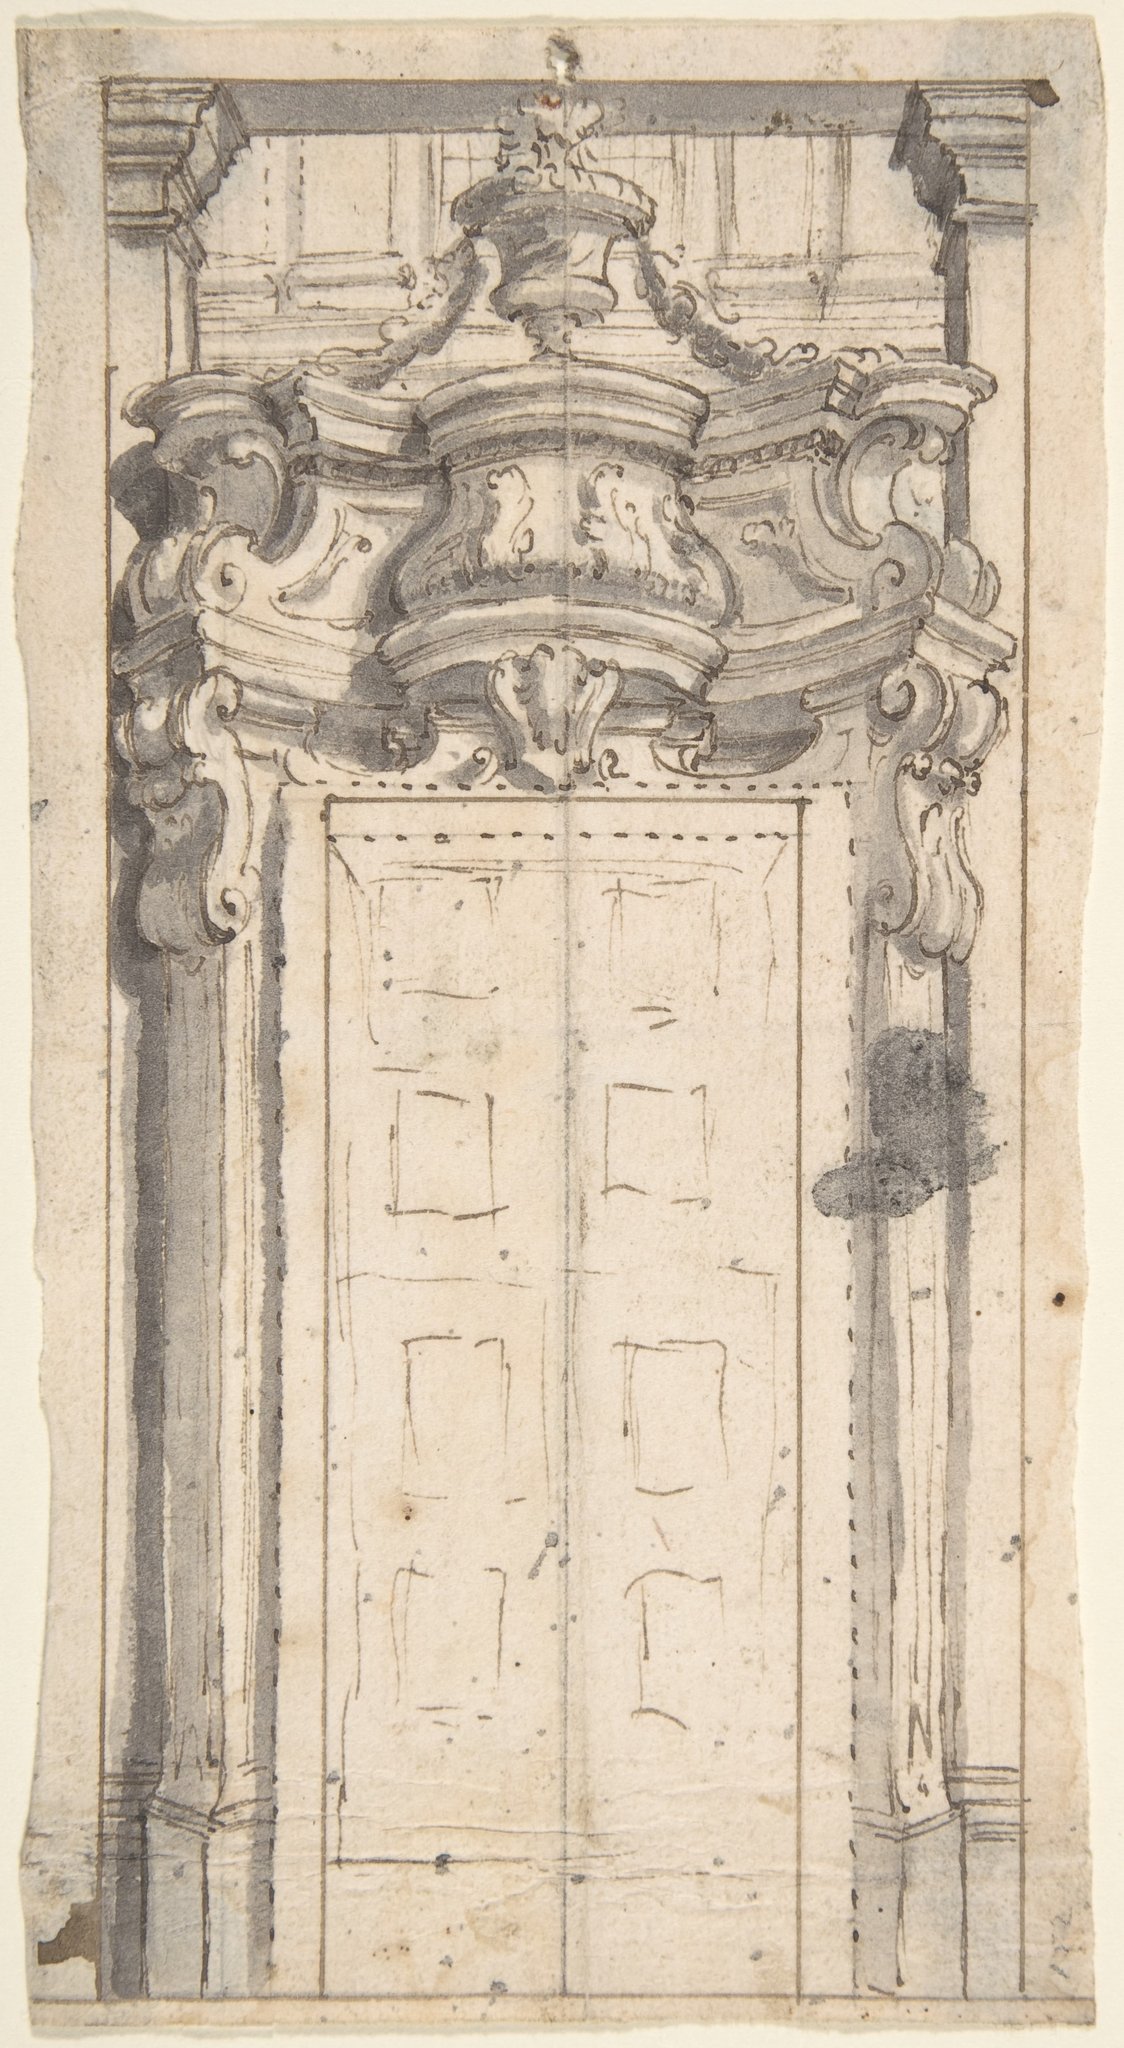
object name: drawing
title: Design for a Doorway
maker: anonymous, italian, piedmontese, 18th century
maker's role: artist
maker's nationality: italian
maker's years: 1700-1800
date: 1700-1780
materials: graphite, ink, drawing material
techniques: brush, pen, wash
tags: architecture,doorways